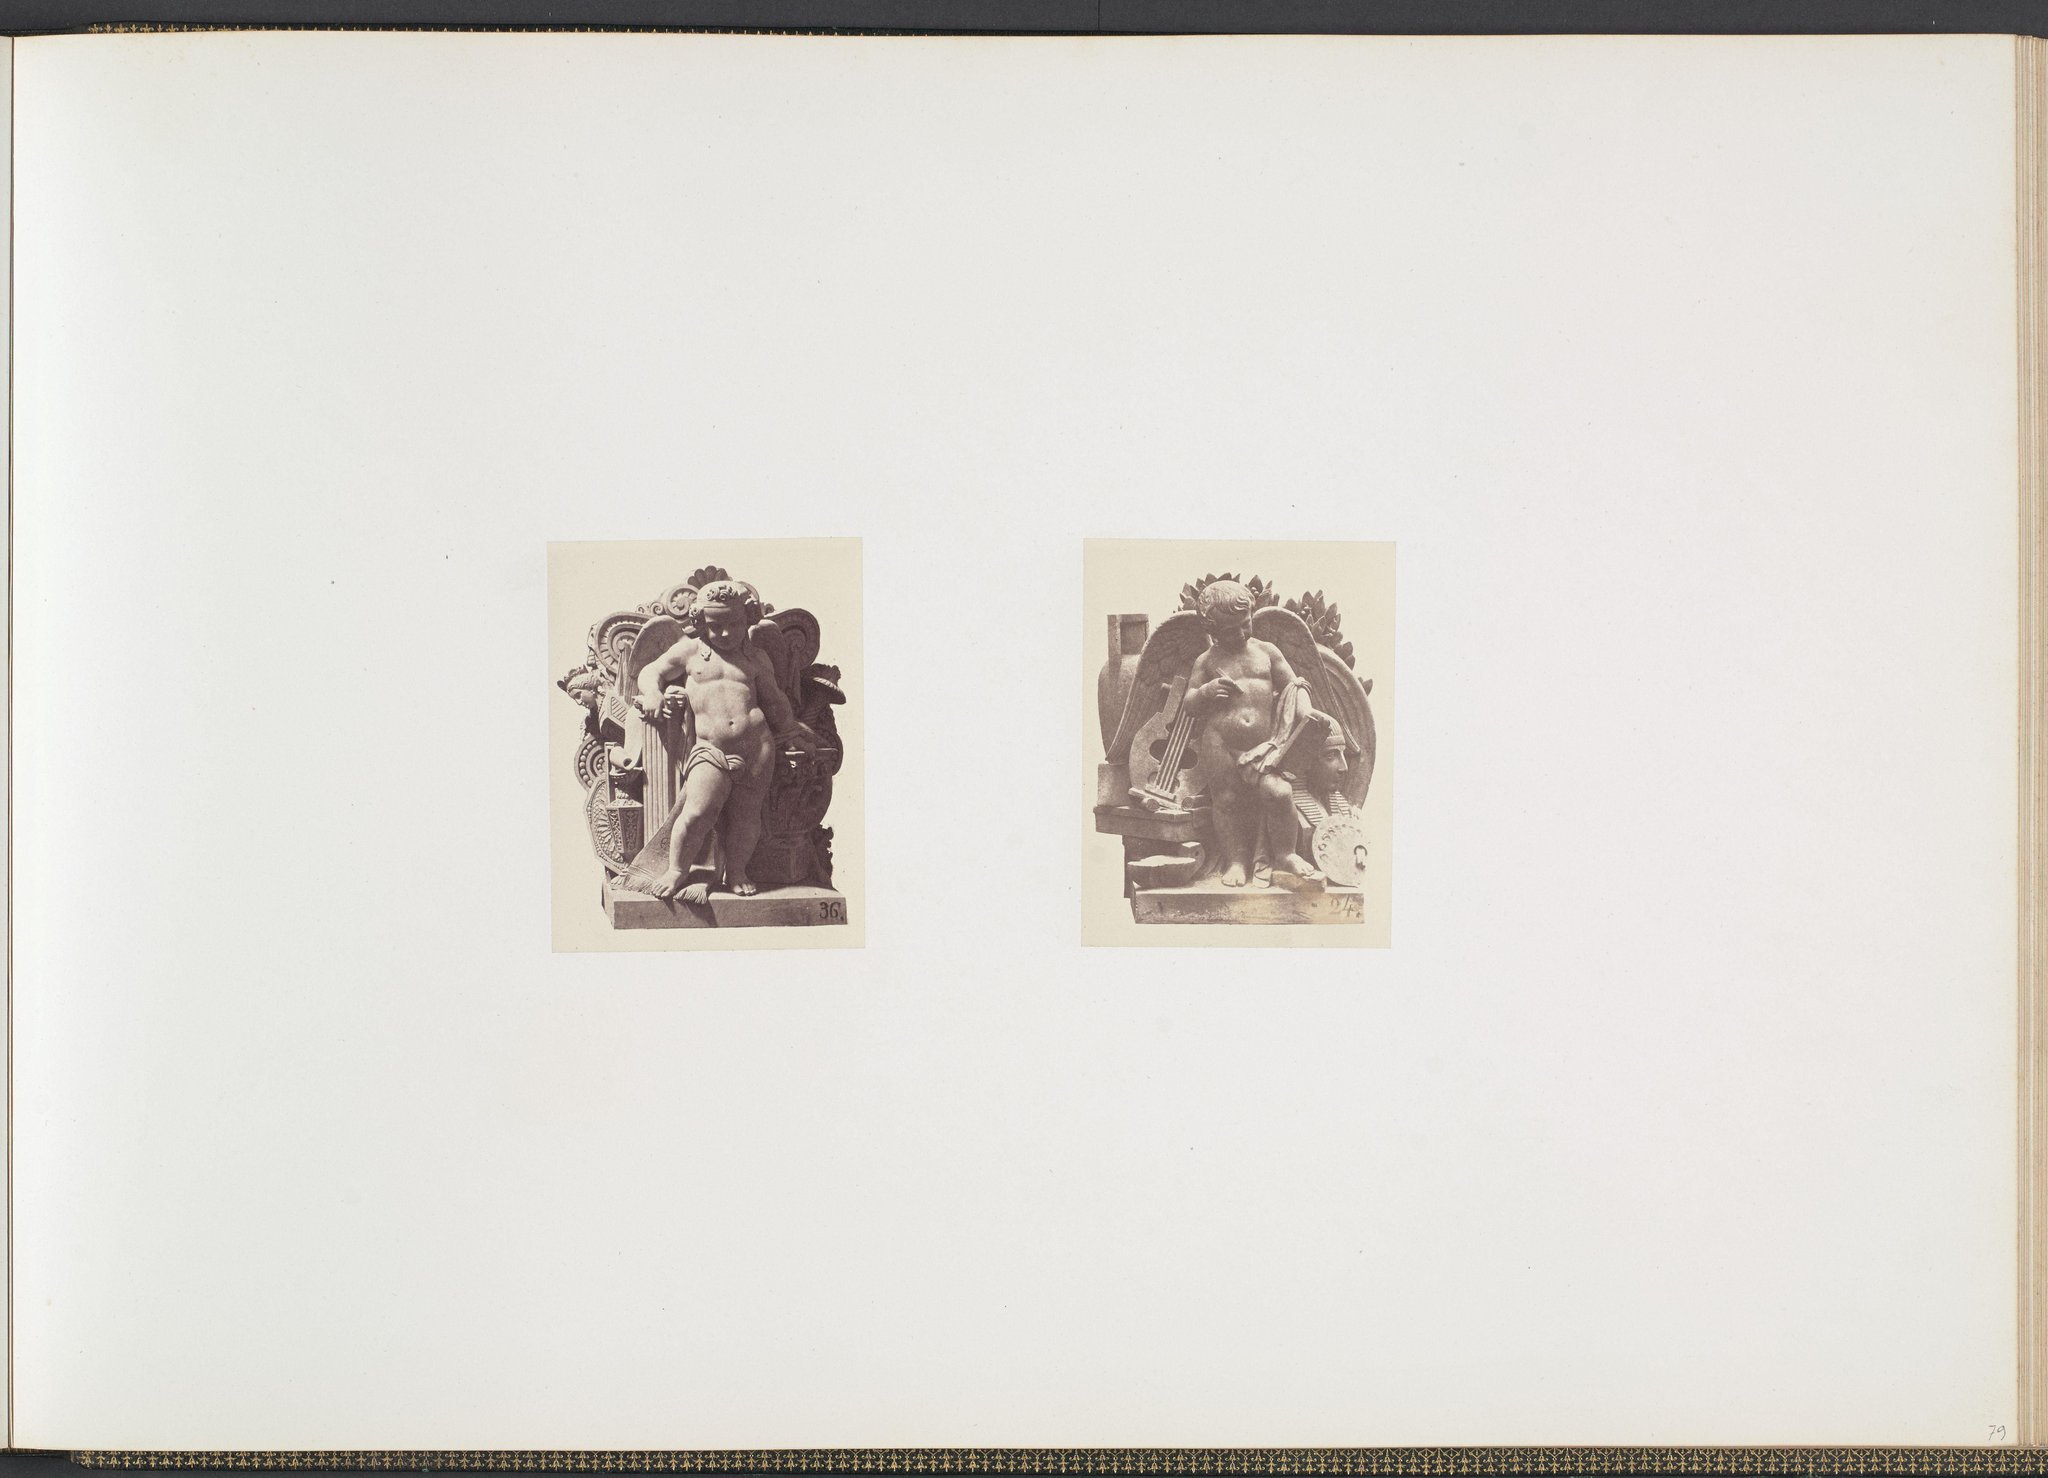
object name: album leaf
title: Gipsmodellen voor beeldhouwwerken op het Palais du Louvre: links "La Renaissance" door Louis Eugène Bion en rechts "Les Beaux-Arts" door Jehan Duseigneur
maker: édouard denis baldus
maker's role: fotograaf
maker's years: 1813-1889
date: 1855-1857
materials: paper, photographic support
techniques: salted paper print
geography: paris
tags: piece of sculpture, reproduction of a piece of sculpture, permanent exhibition, museum, paris, tuileries palace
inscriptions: number: ‘36 en 24’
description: Onderdeel van Réunion des Tuileries au Louvre 1852-1857, album 2.